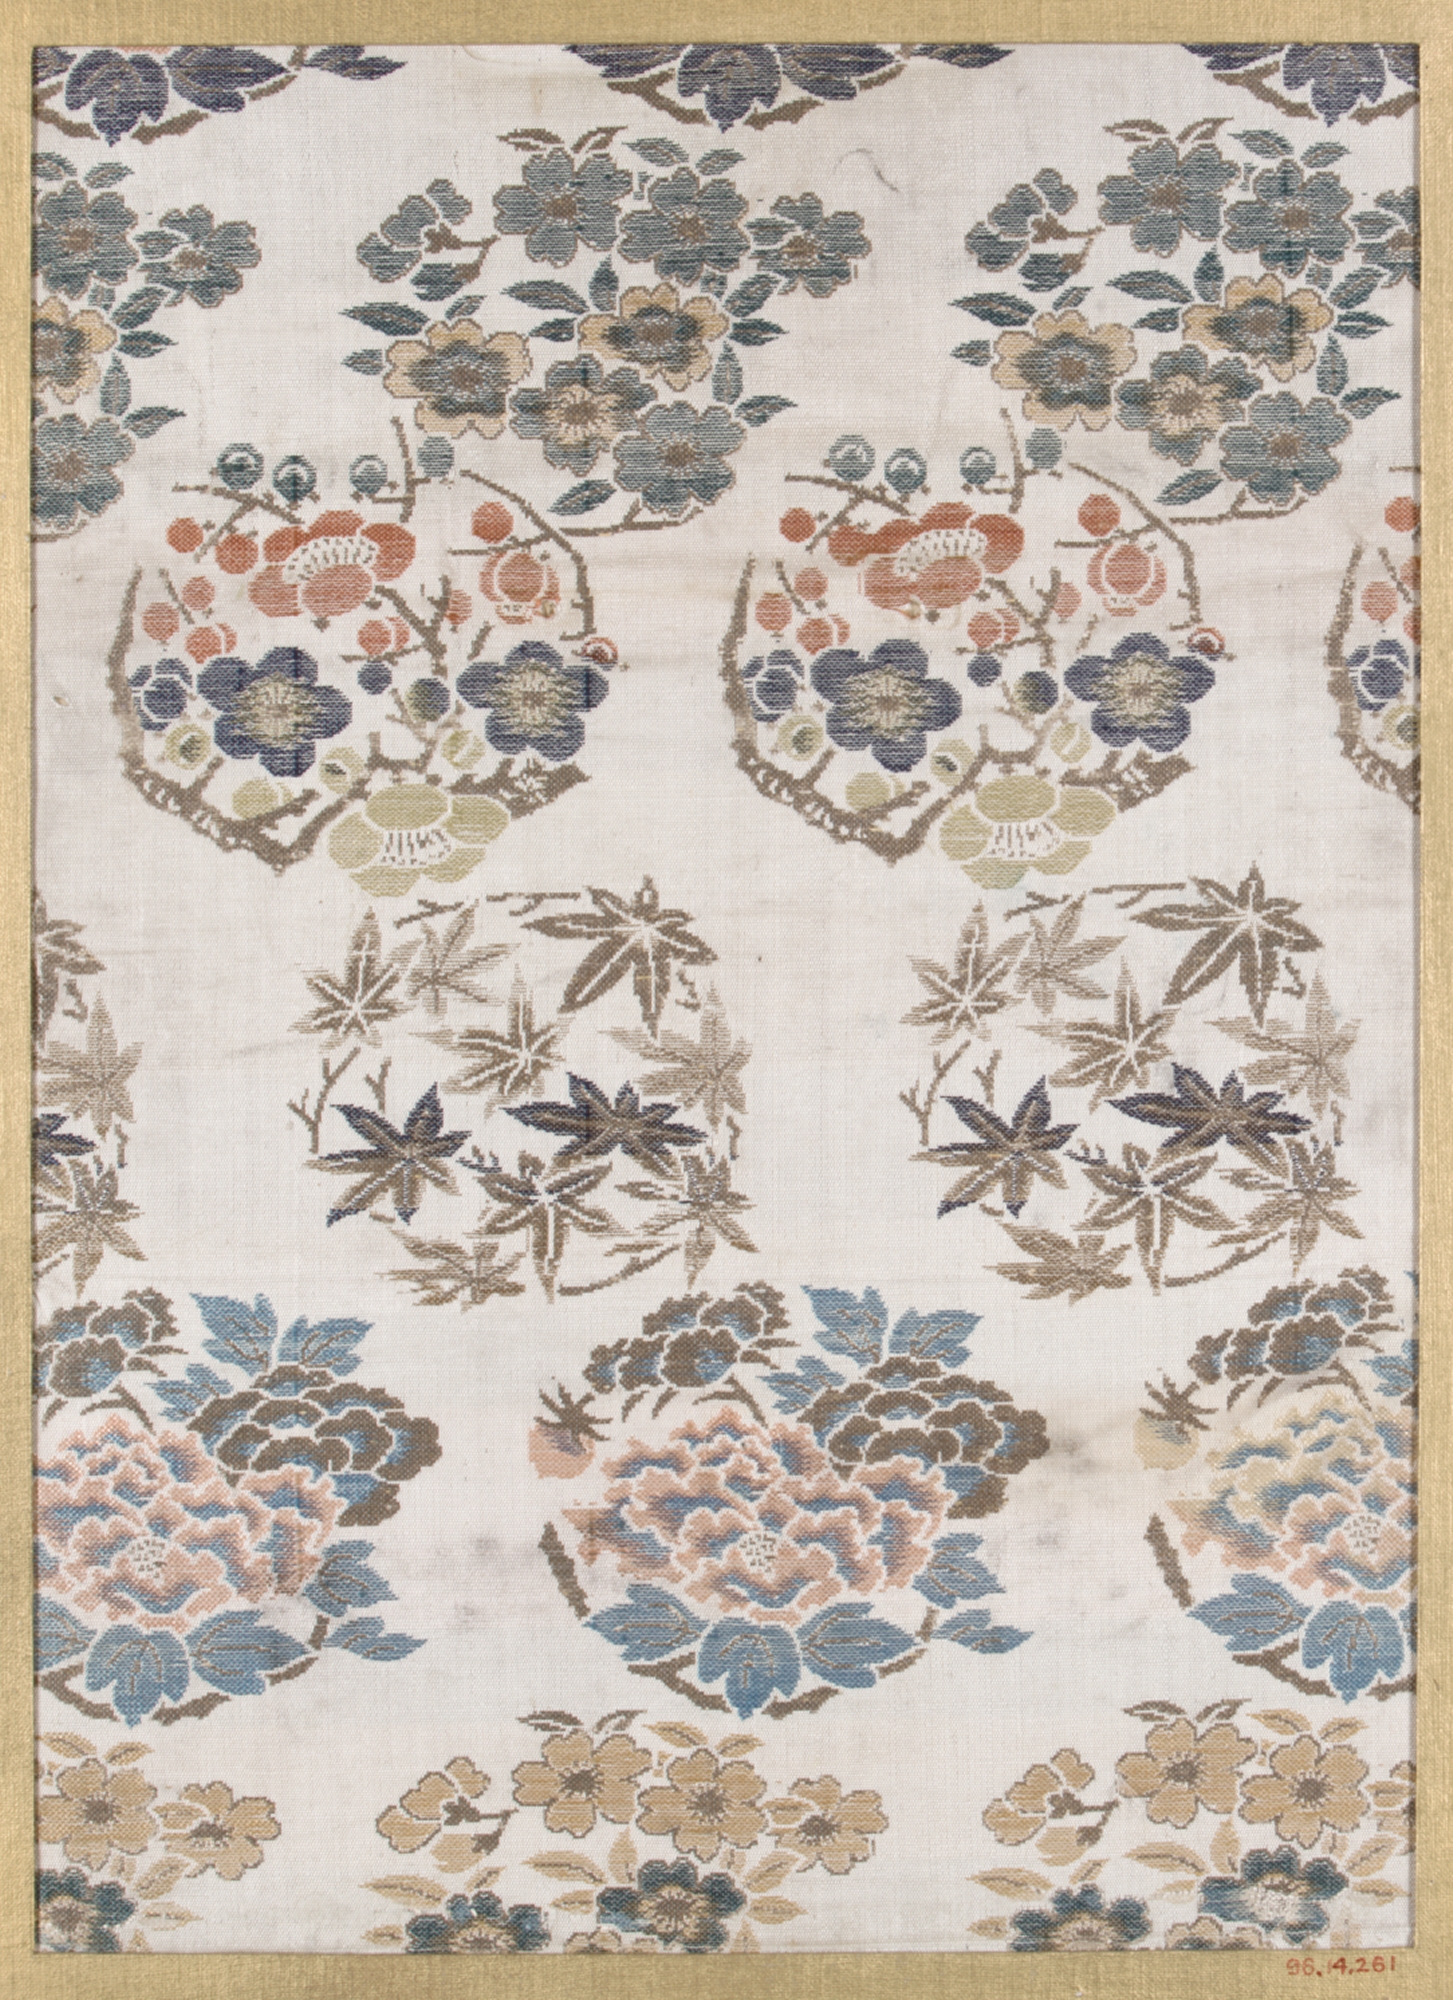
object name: piece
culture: japanese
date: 1701-1900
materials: silk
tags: leaves